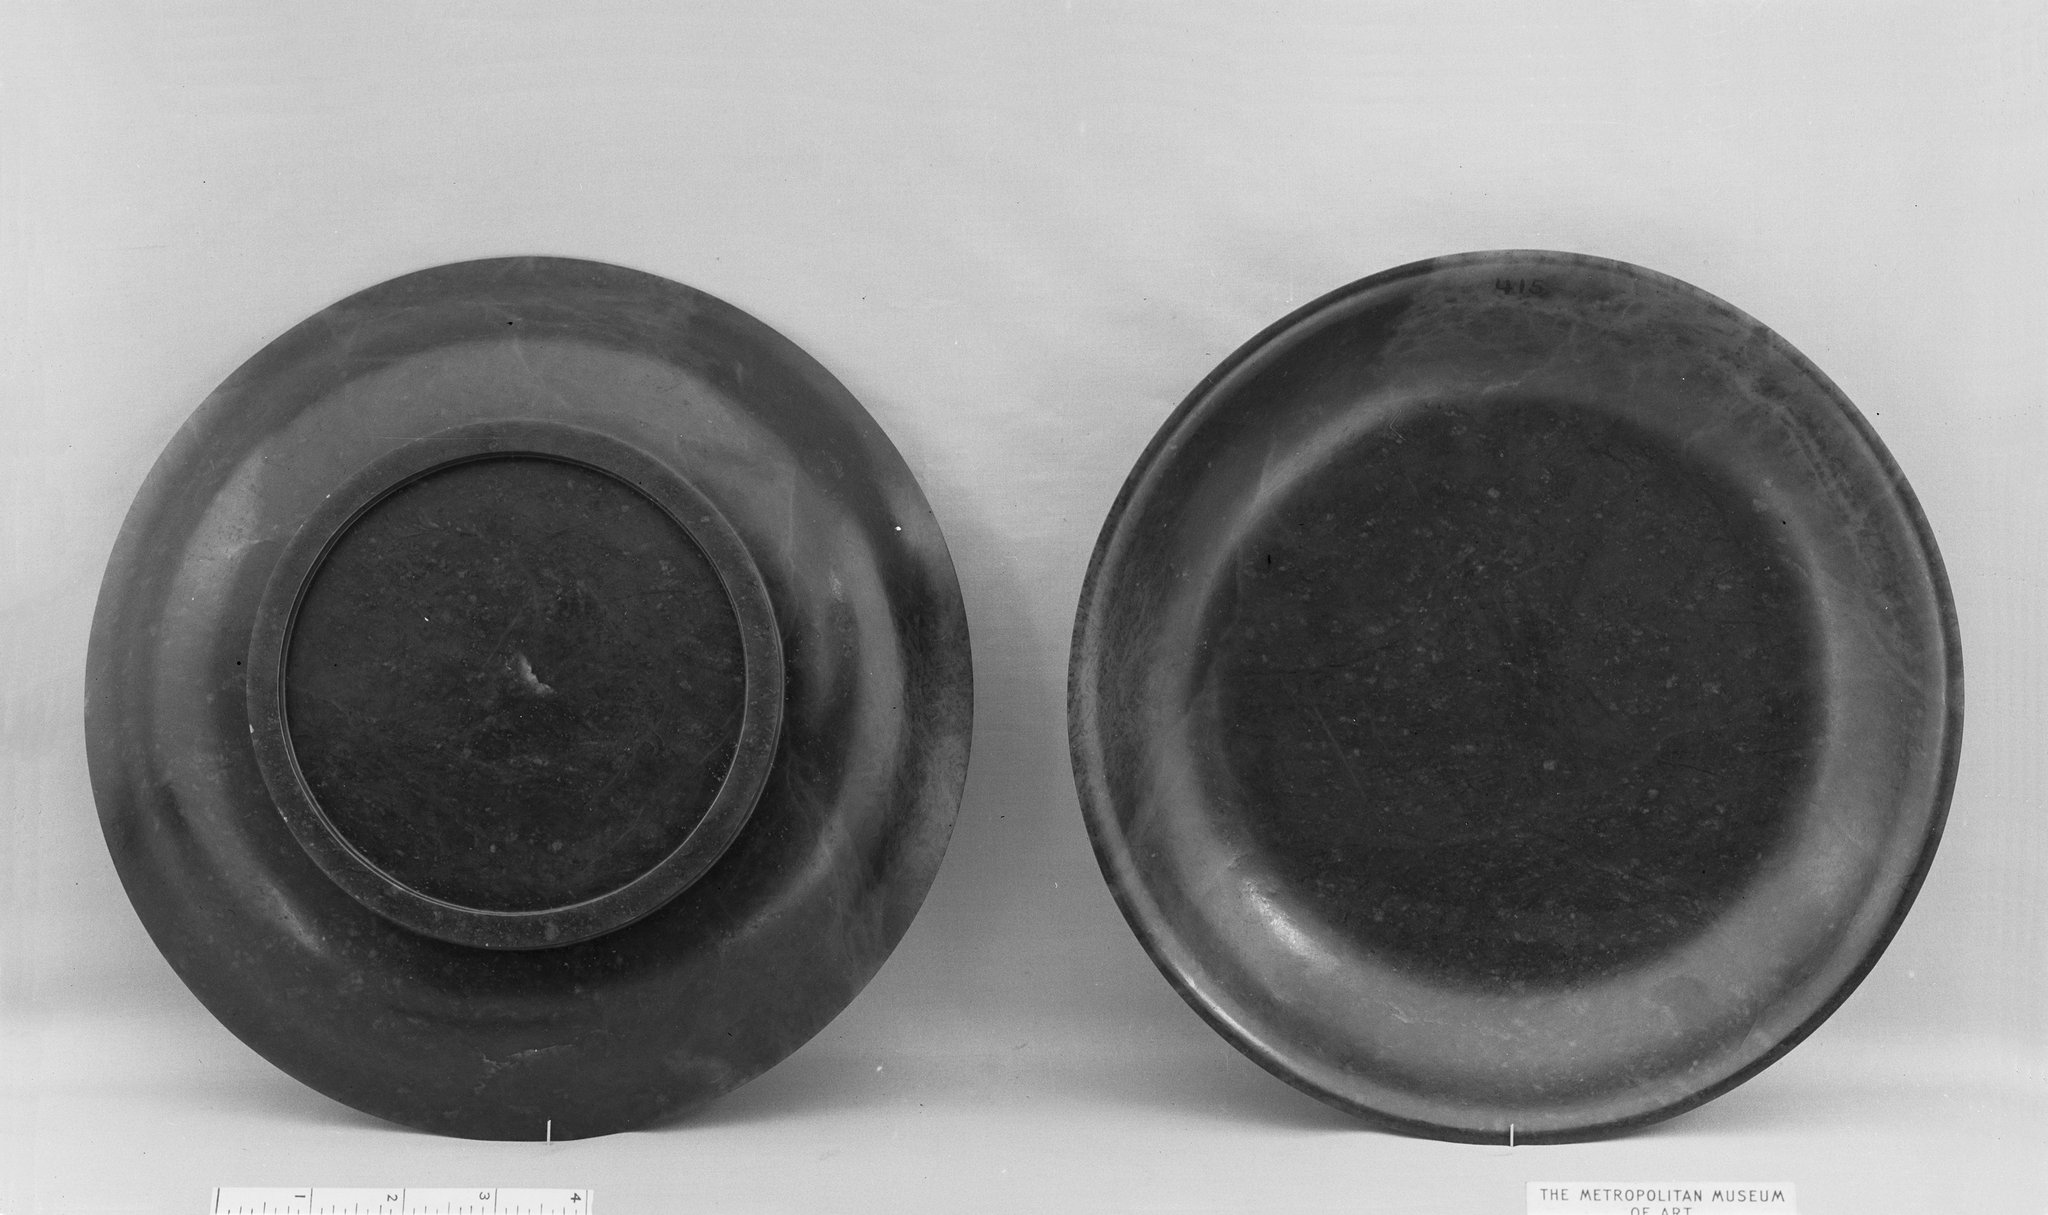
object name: dish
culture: chinese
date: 1368-1644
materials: jade